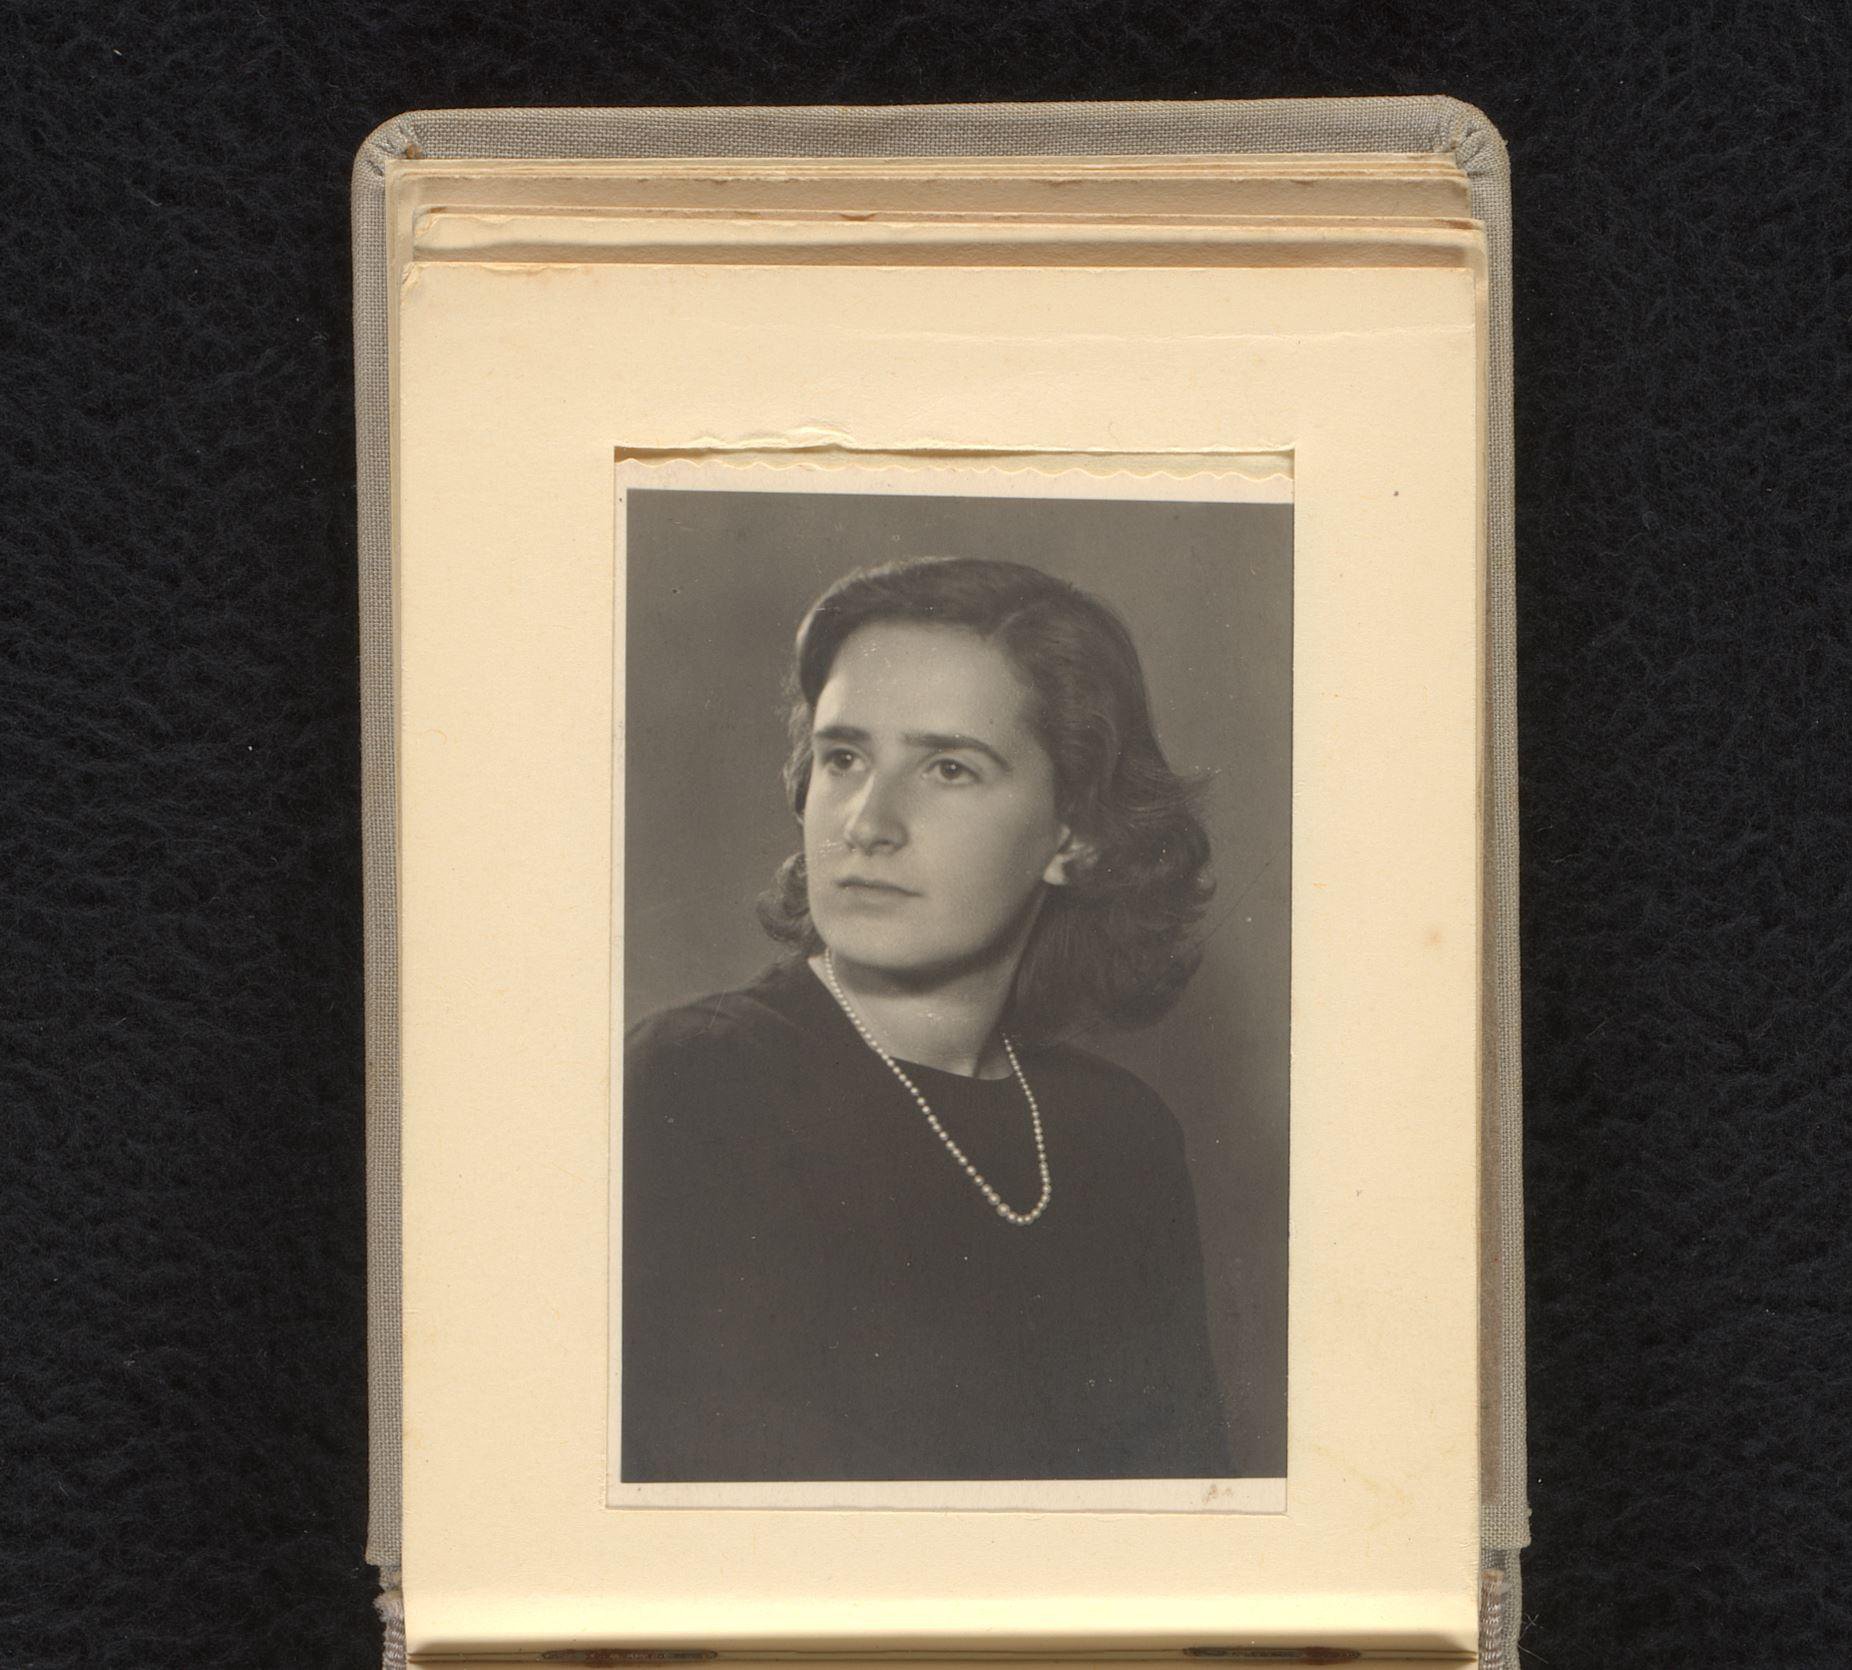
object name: photograph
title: Portret van Isabel Wachenheimer als jonge vrouw, 1945-1963, Duitsland / Israël / Zwitserland / Verenigde Staten?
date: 1945-1963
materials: paper, photographic support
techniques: gelatin silver print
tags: leiden, isabel wachenheimer-elon, historical persons - bb - woman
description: Albumblad bevat een foto van Isabel Wachenheimer. Onderdeel van het fotoalbum met diverse foto's van de jeugd van Isabel Wachenheimer voor en tijdens de oorlog en diverse momenten van haar volwassen leven na de Tweede Wereldoorlog.